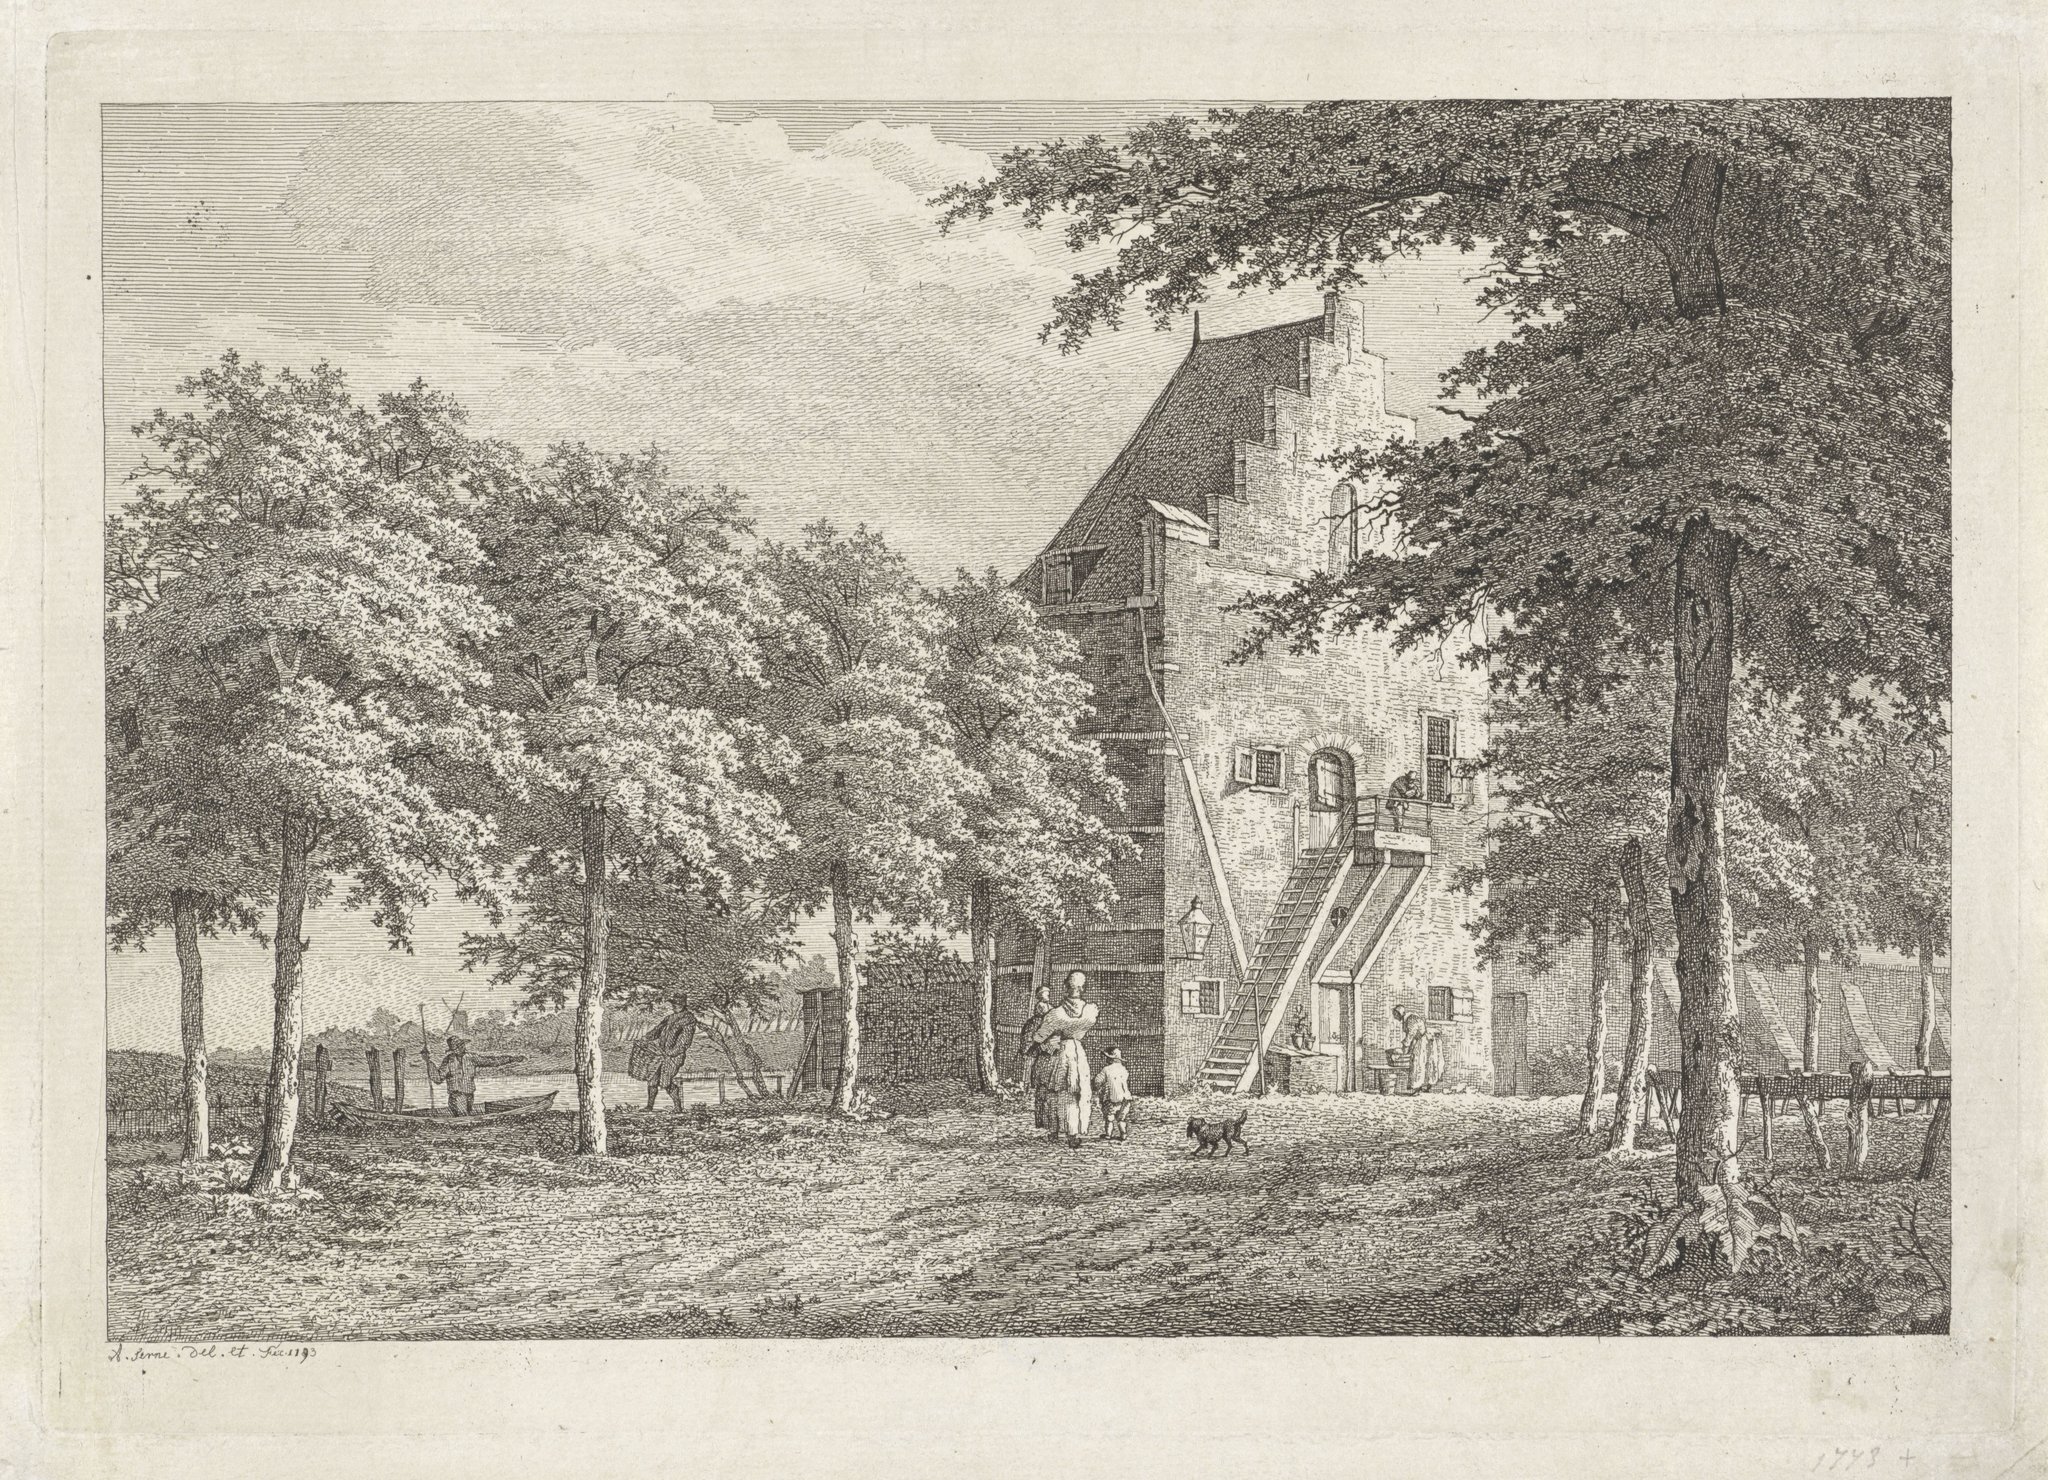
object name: print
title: Landschap met huis met hoge trap naar de eerste verdieping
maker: adrianus serné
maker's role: print maker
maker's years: 1773-1853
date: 1793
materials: paper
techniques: engraving, etching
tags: civic architecture; edifices; dwellings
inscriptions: collector's mark: Lugt 2228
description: Gezicht op een huis met hoge trap naar de eerste verdieping. Op de voorgrond een vrouw met kind op de arm en een kind naast haar. Links een man in een sloep en een man die een mand tilt.